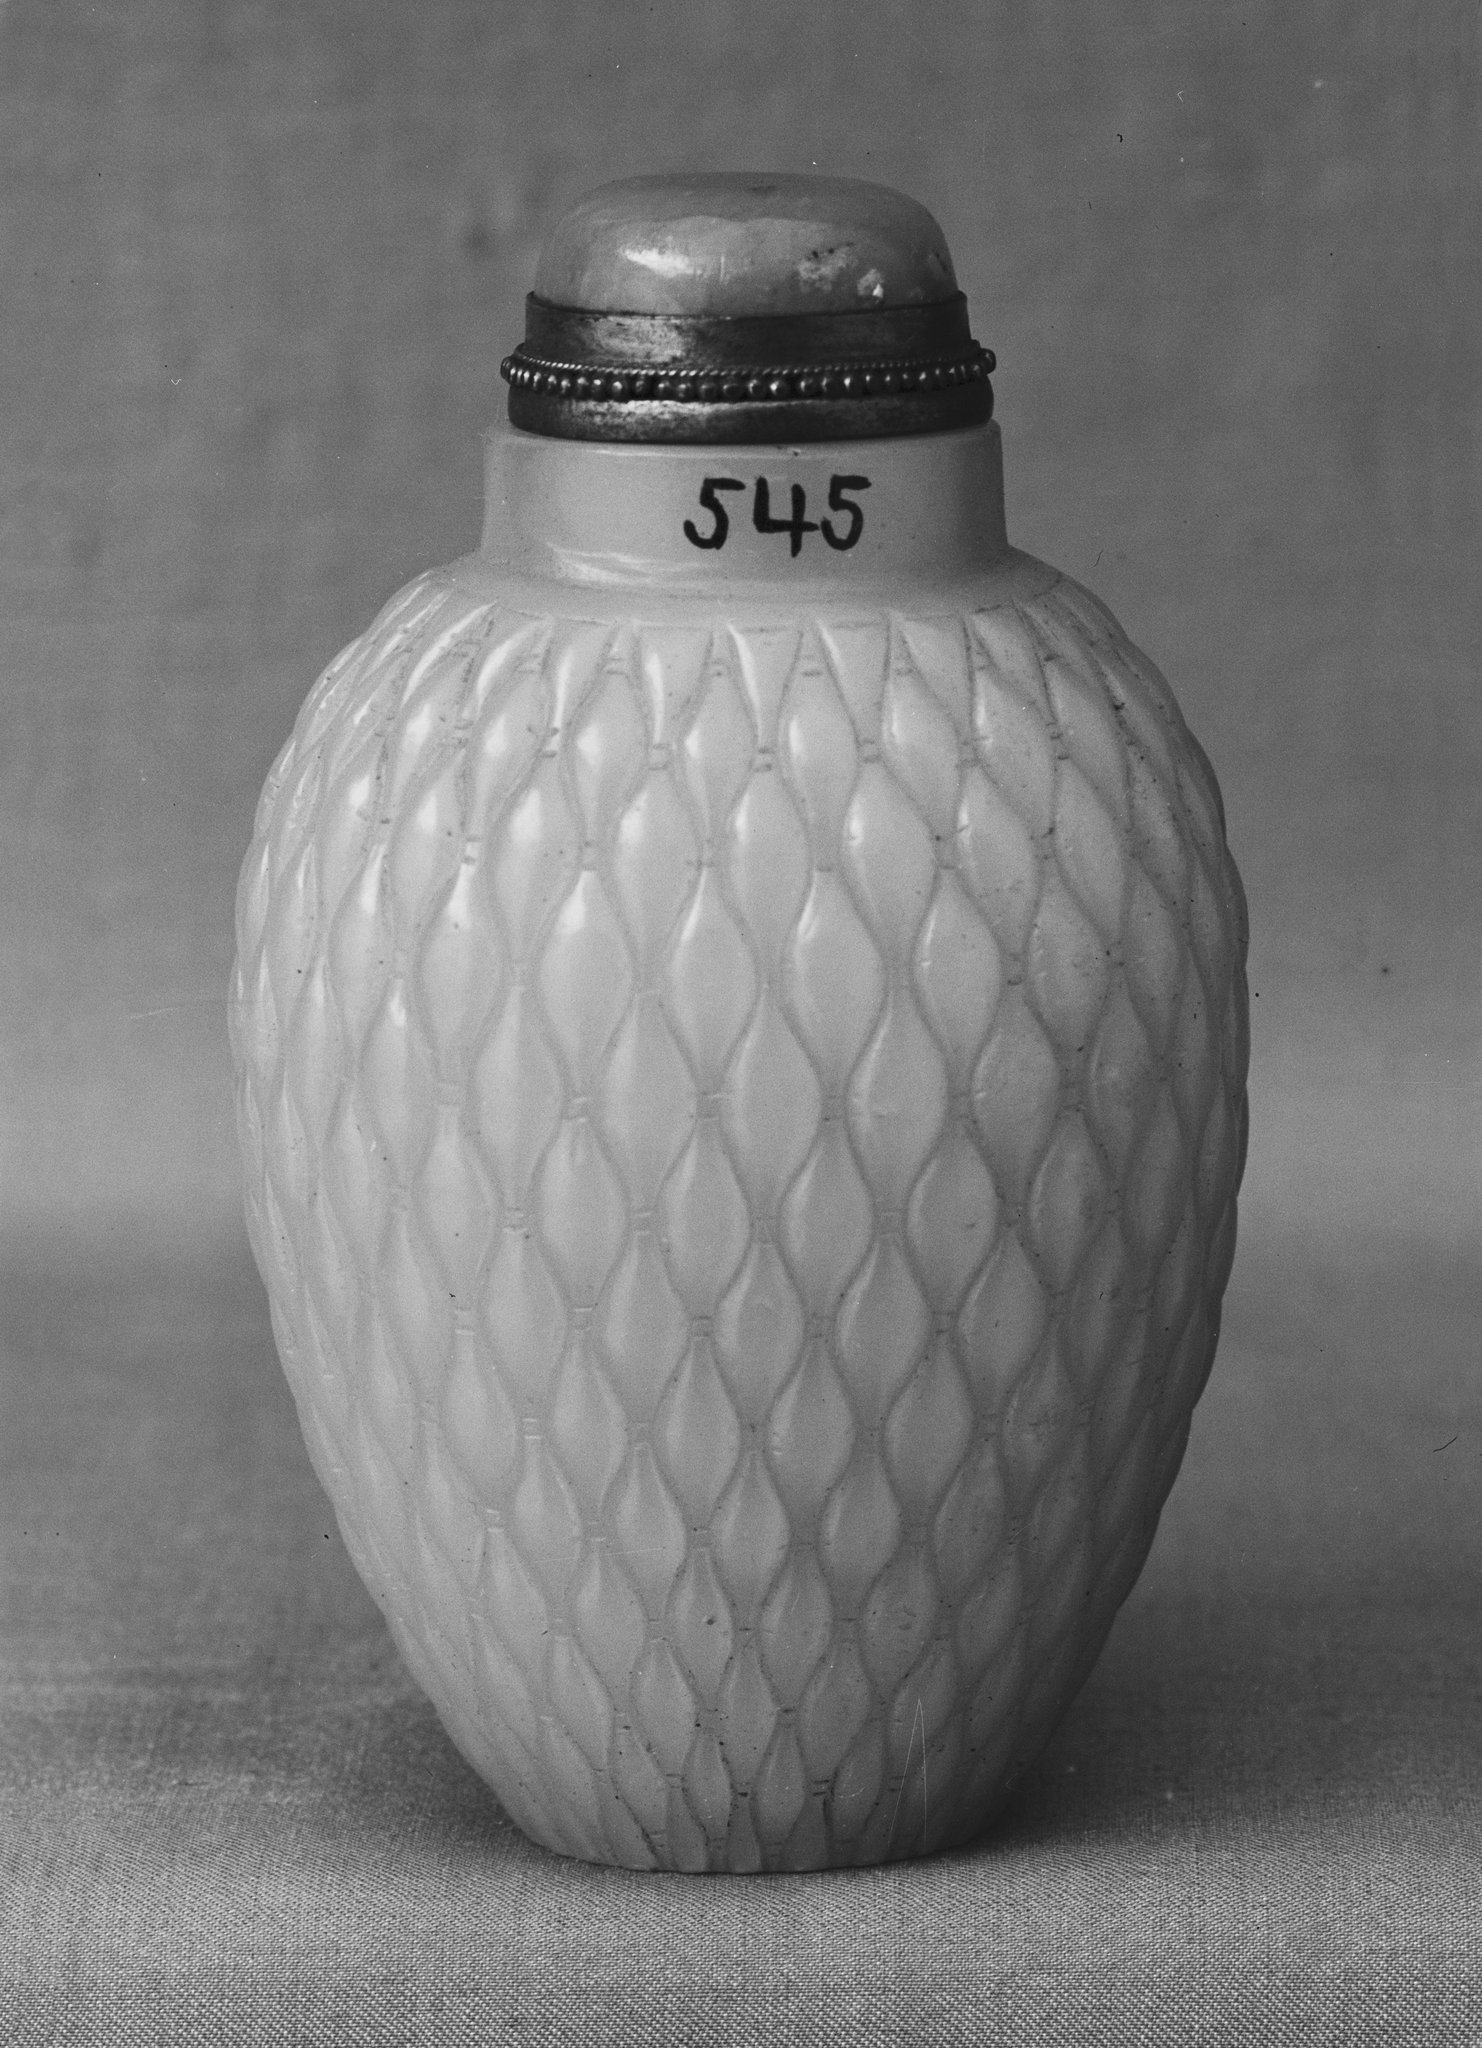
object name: snuff bottle with stopper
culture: chinese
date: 1736-1795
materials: jade